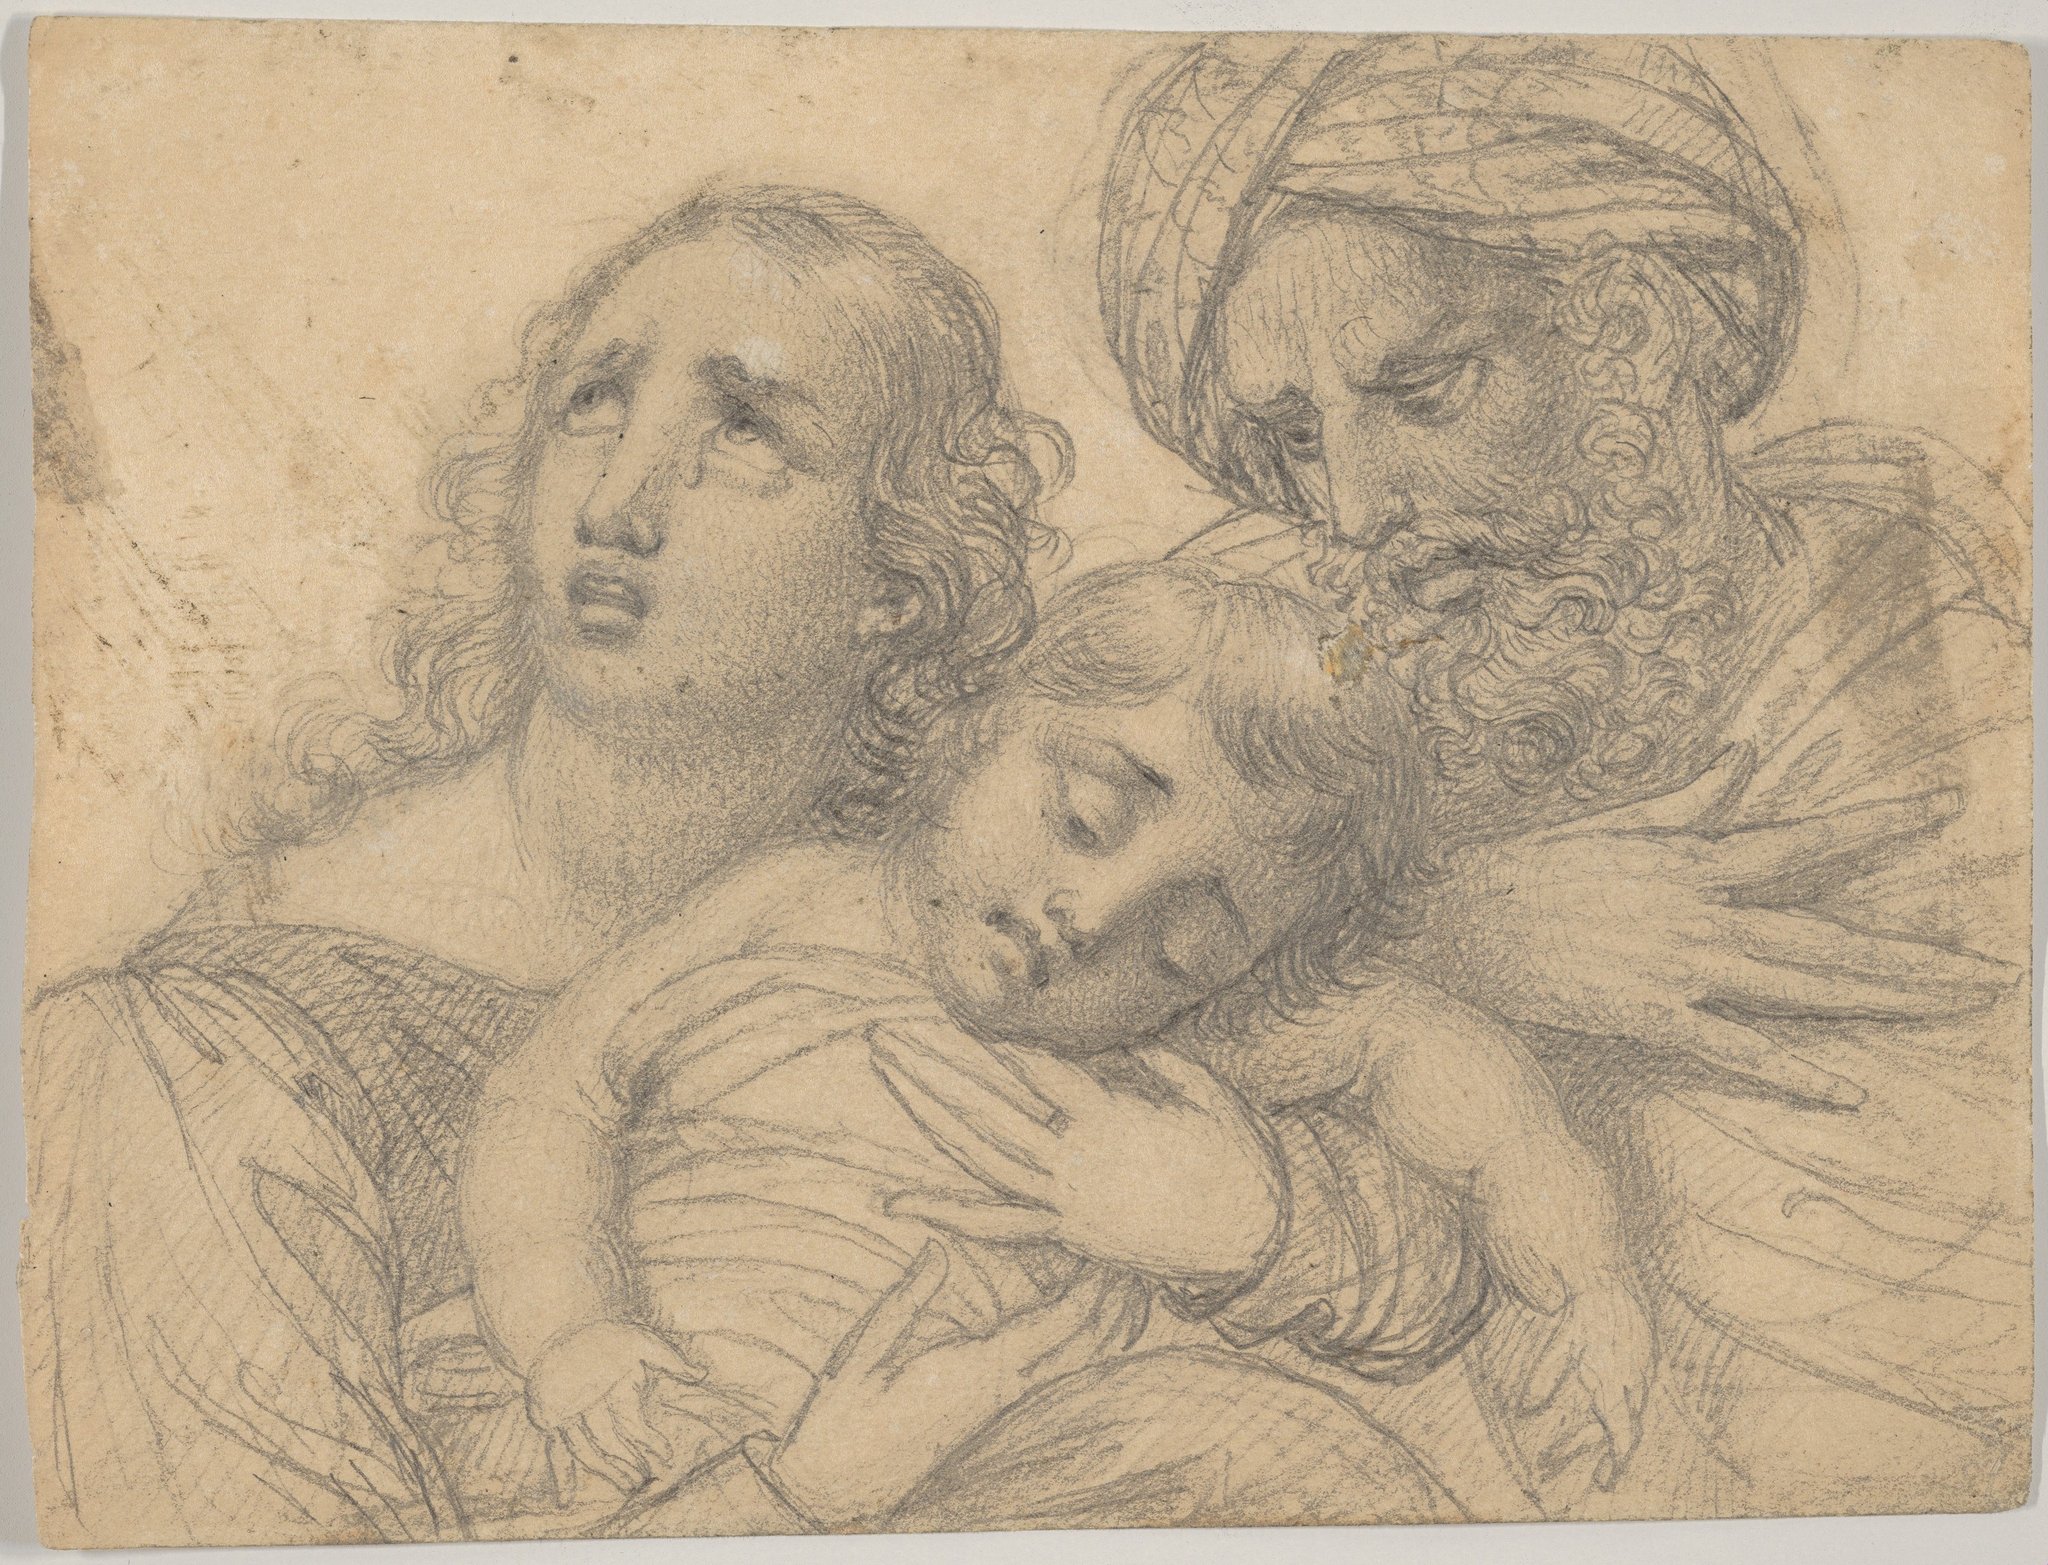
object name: drawing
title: A Woman and a Turbaned Man in Despair with a Young Child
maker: françois joseph navez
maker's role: artist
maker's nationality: belgian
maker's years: 1787-1869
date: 1807-1869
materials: graphite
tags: infants,men,women